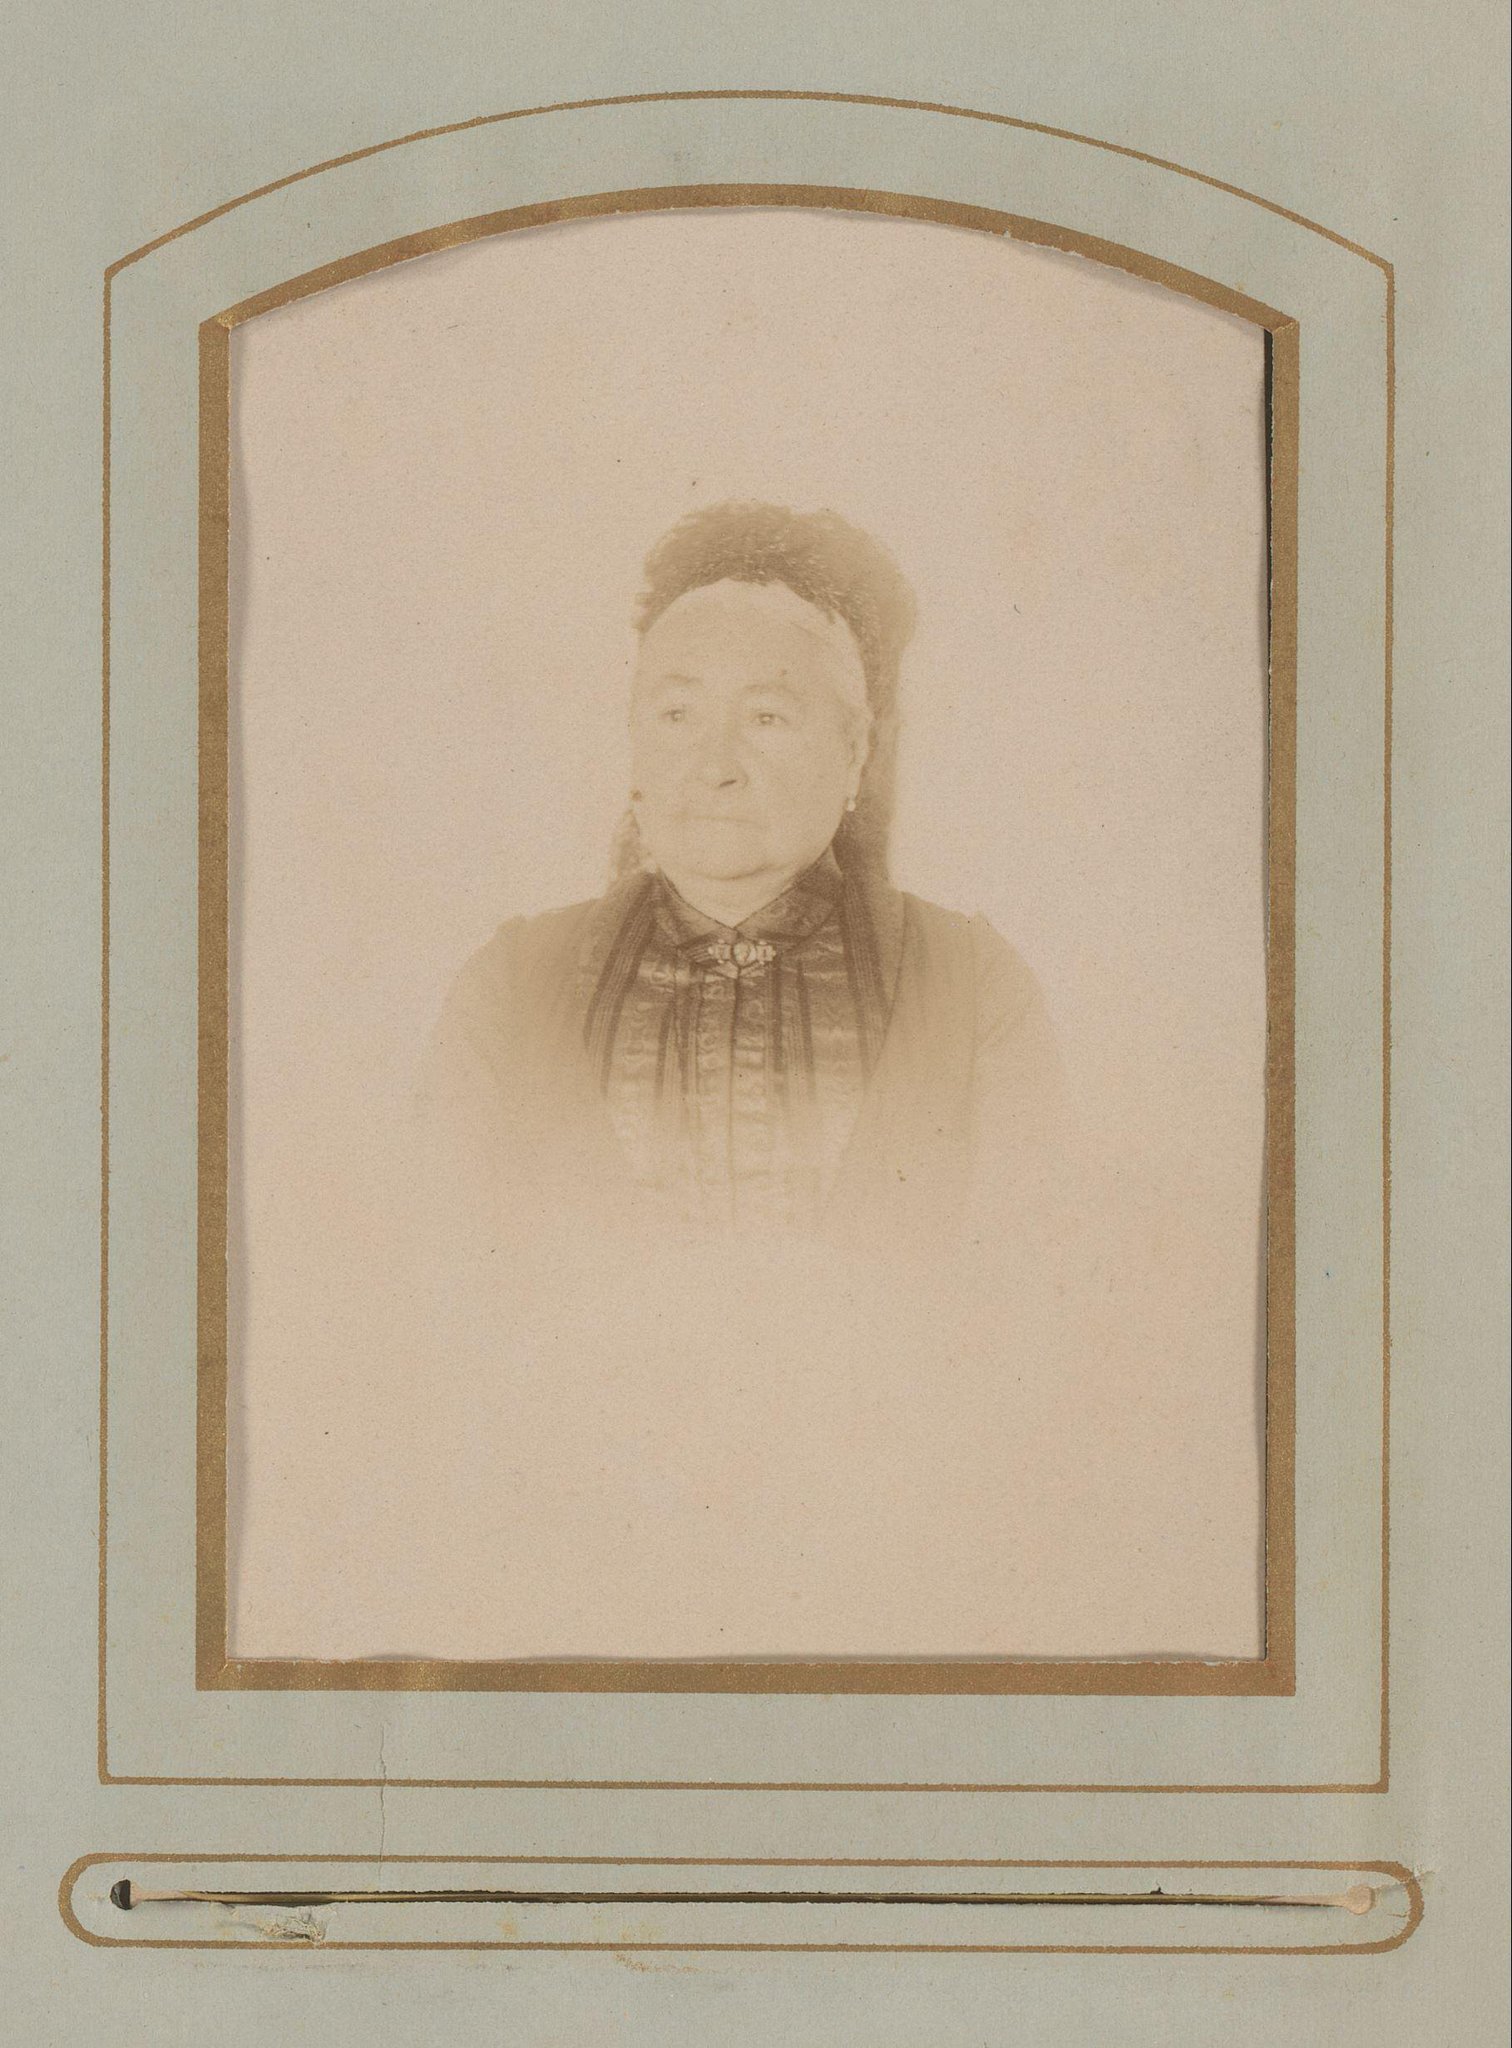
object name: cabinet photograph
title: Portret van een vrouw met muts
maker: Anonymous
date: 1860-1900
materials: cardboard, photographic support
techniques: albumen print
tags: historical persons - bb - woman, head-gear: cap